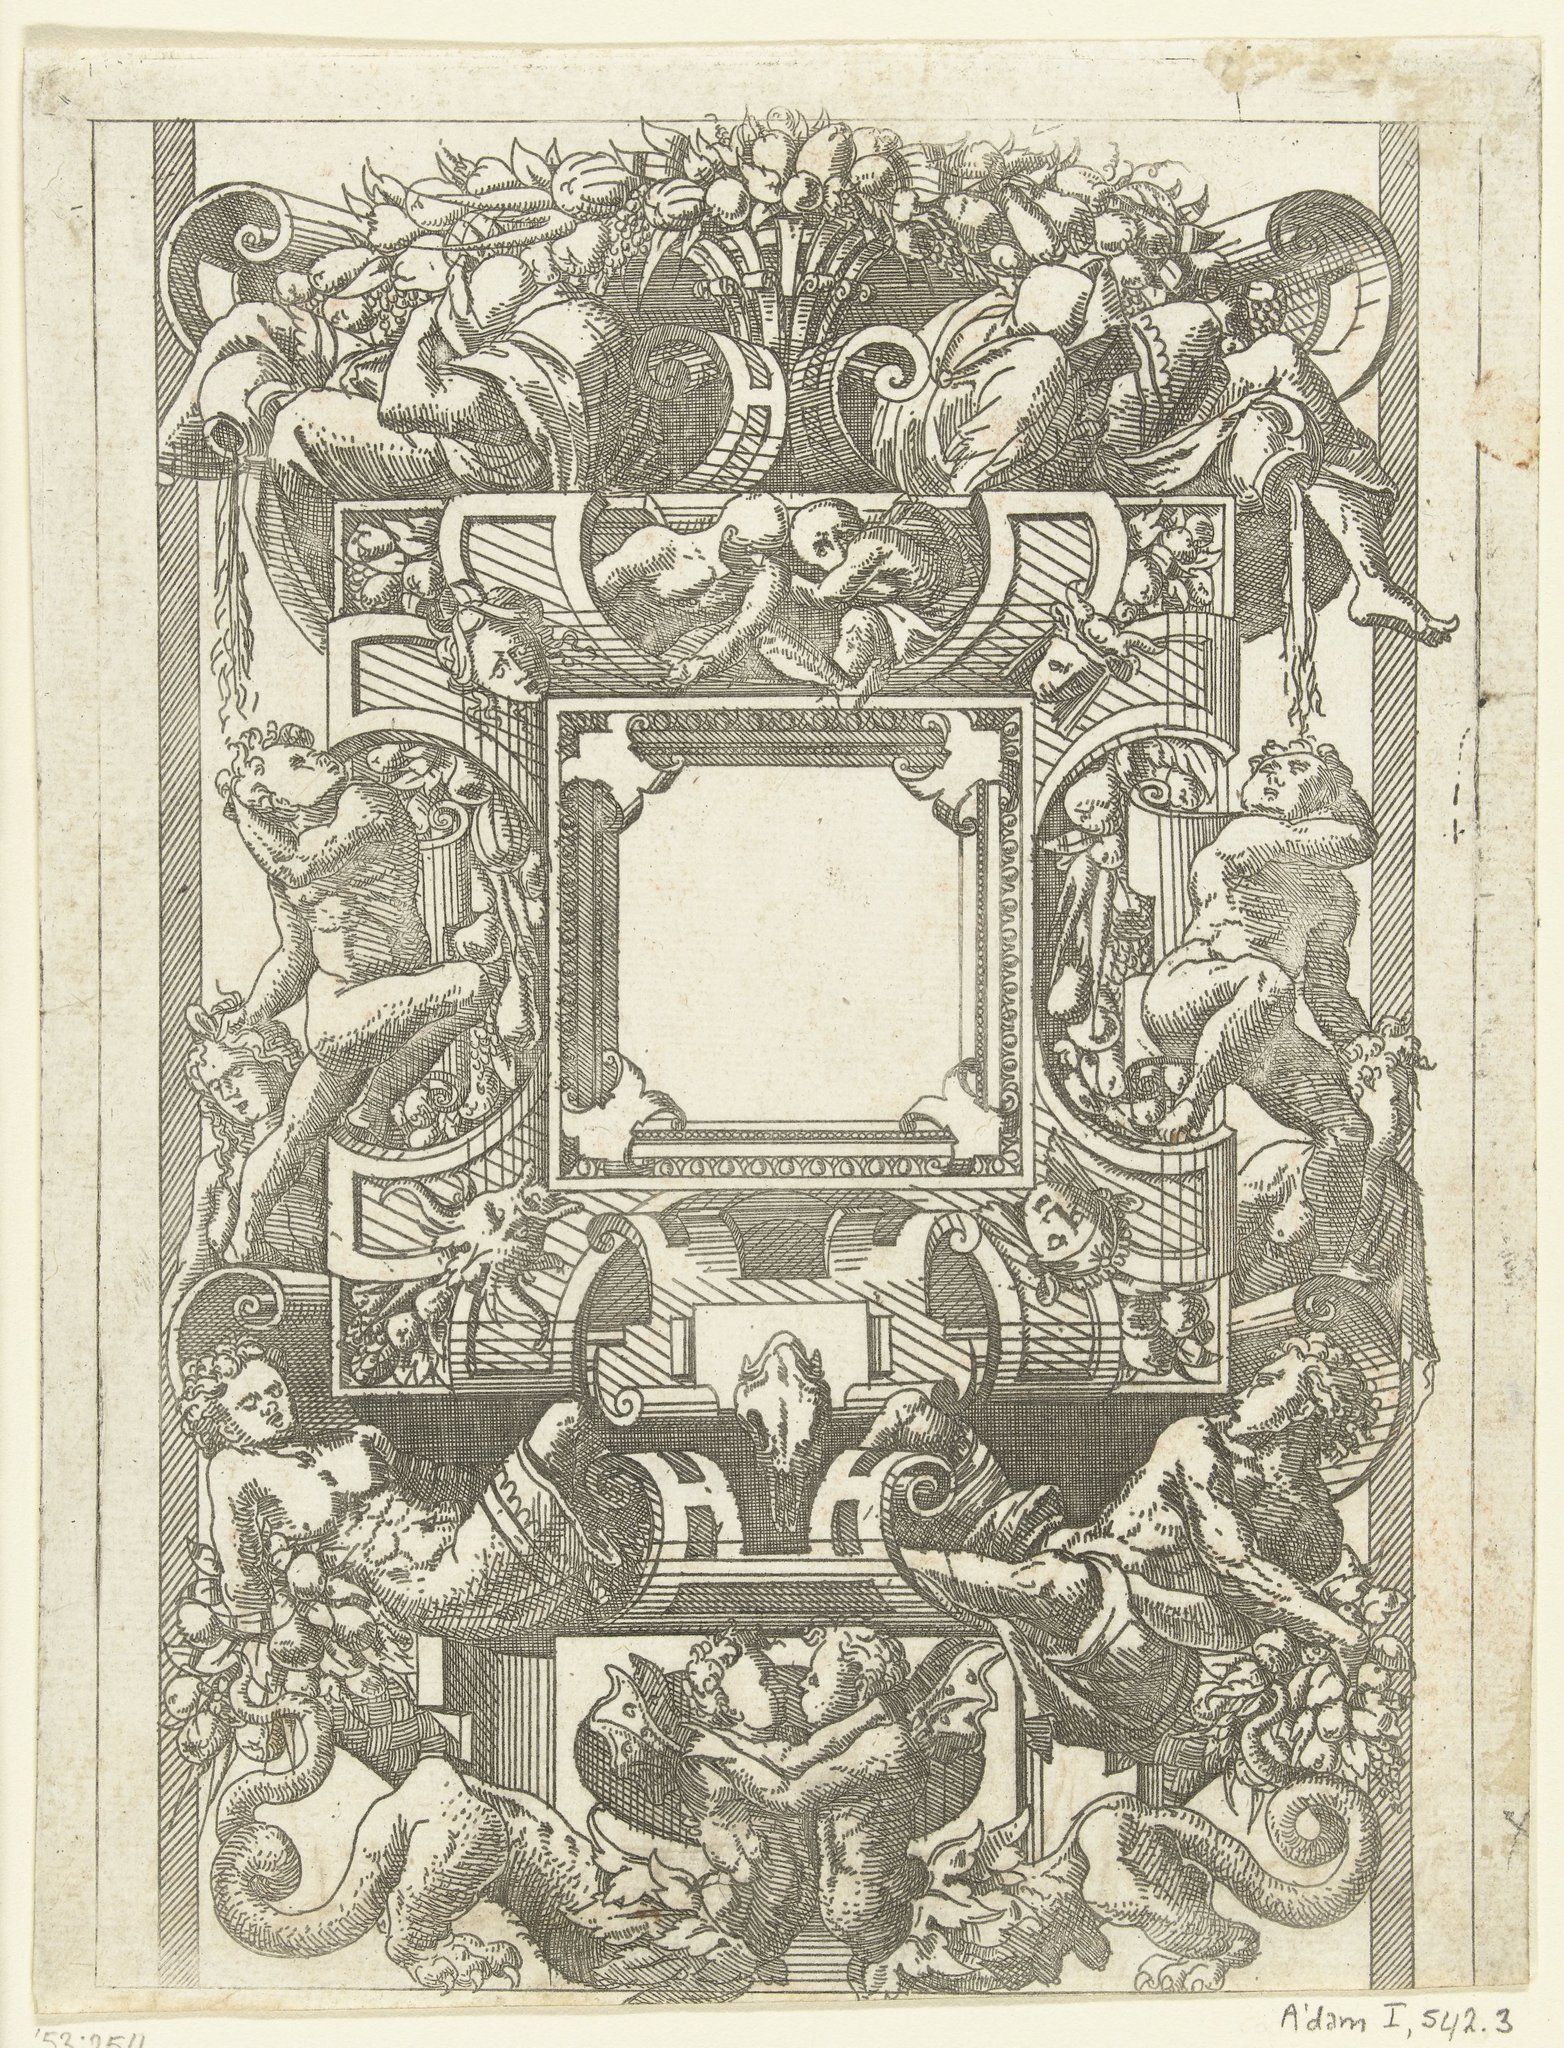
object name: ornament print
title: Vierkante cartouche, in een brede lijst van rolwerk met guirlandes van vruchten en kinderen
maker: Anonymous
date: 1520-1584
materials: paper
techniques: etching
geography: france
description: Links en rechts staat een kind dat een vrouwenhoofd bij de haren vasthoudt. Uit serie van 32 bladen. De cartouches zijn deels ontleend aan de prenten van Antonio Fantuzzi naar de decoratie van de Galerie van François 1er door Giovanni Battista Rosso. De serie staat ook bekend onder de titel Petits cartouches de Fontainebleau.